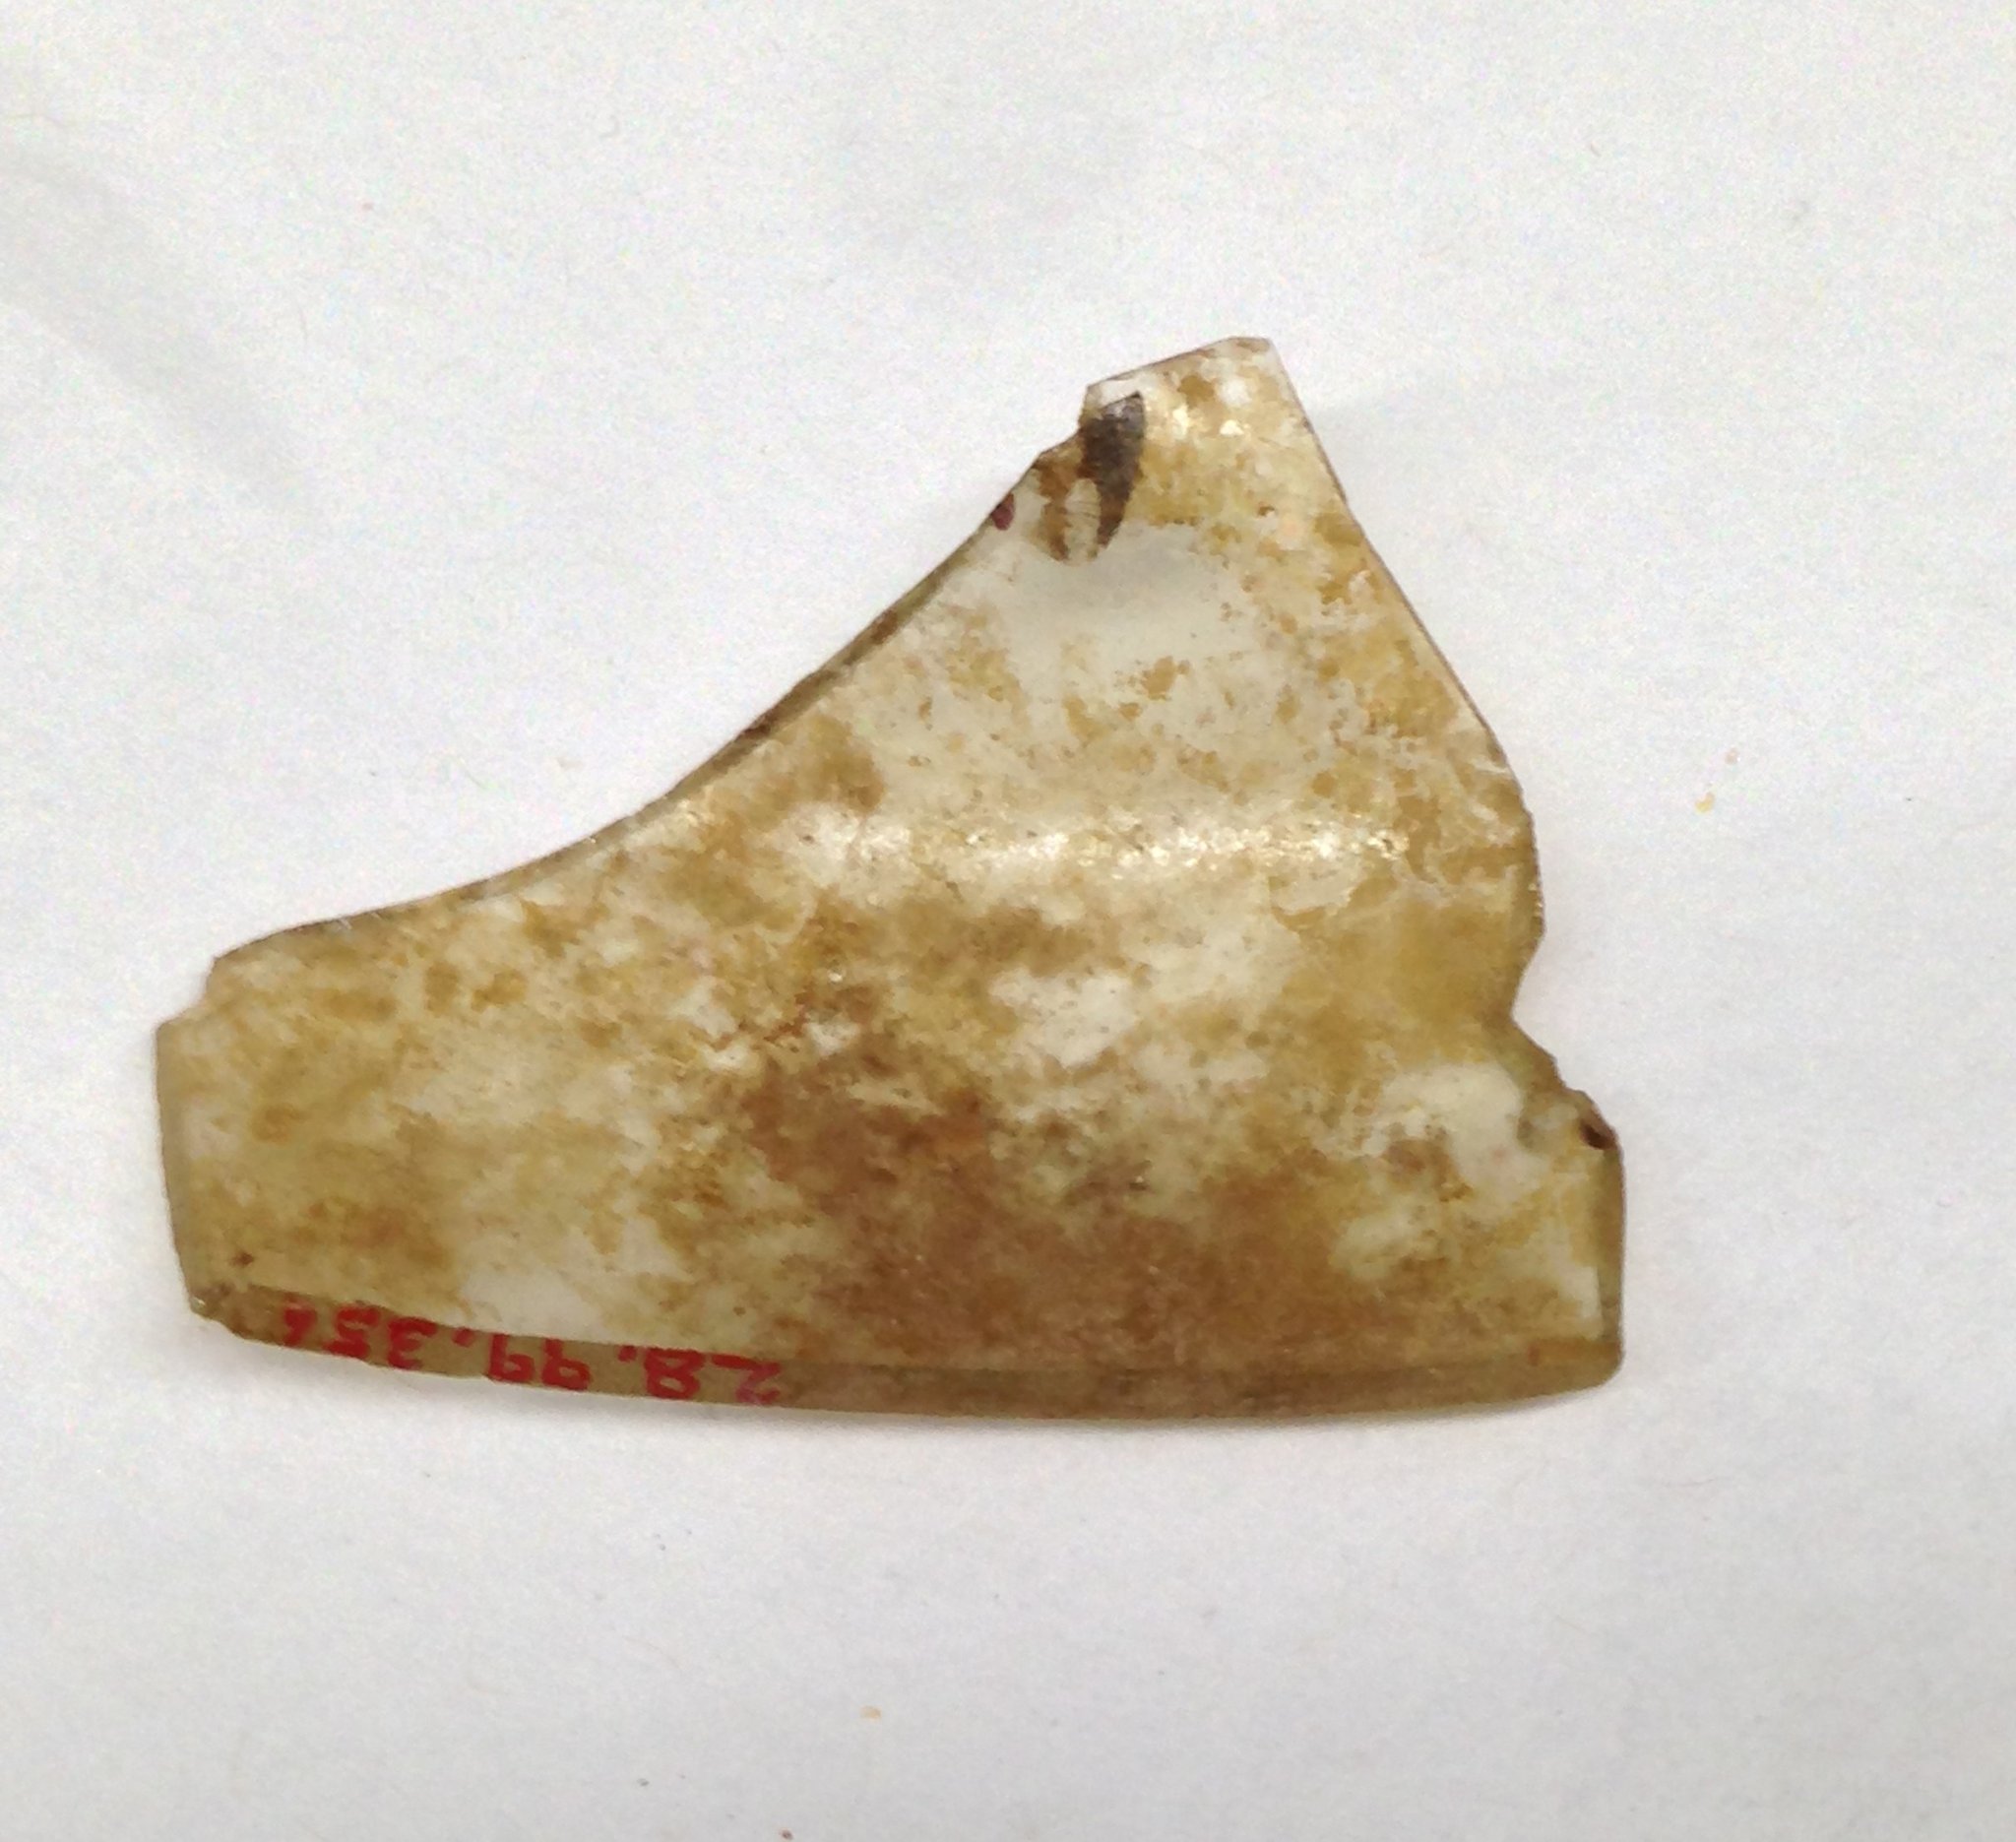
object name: fragment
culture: european or middle eastern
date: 1150-1250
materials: ceramic, glass